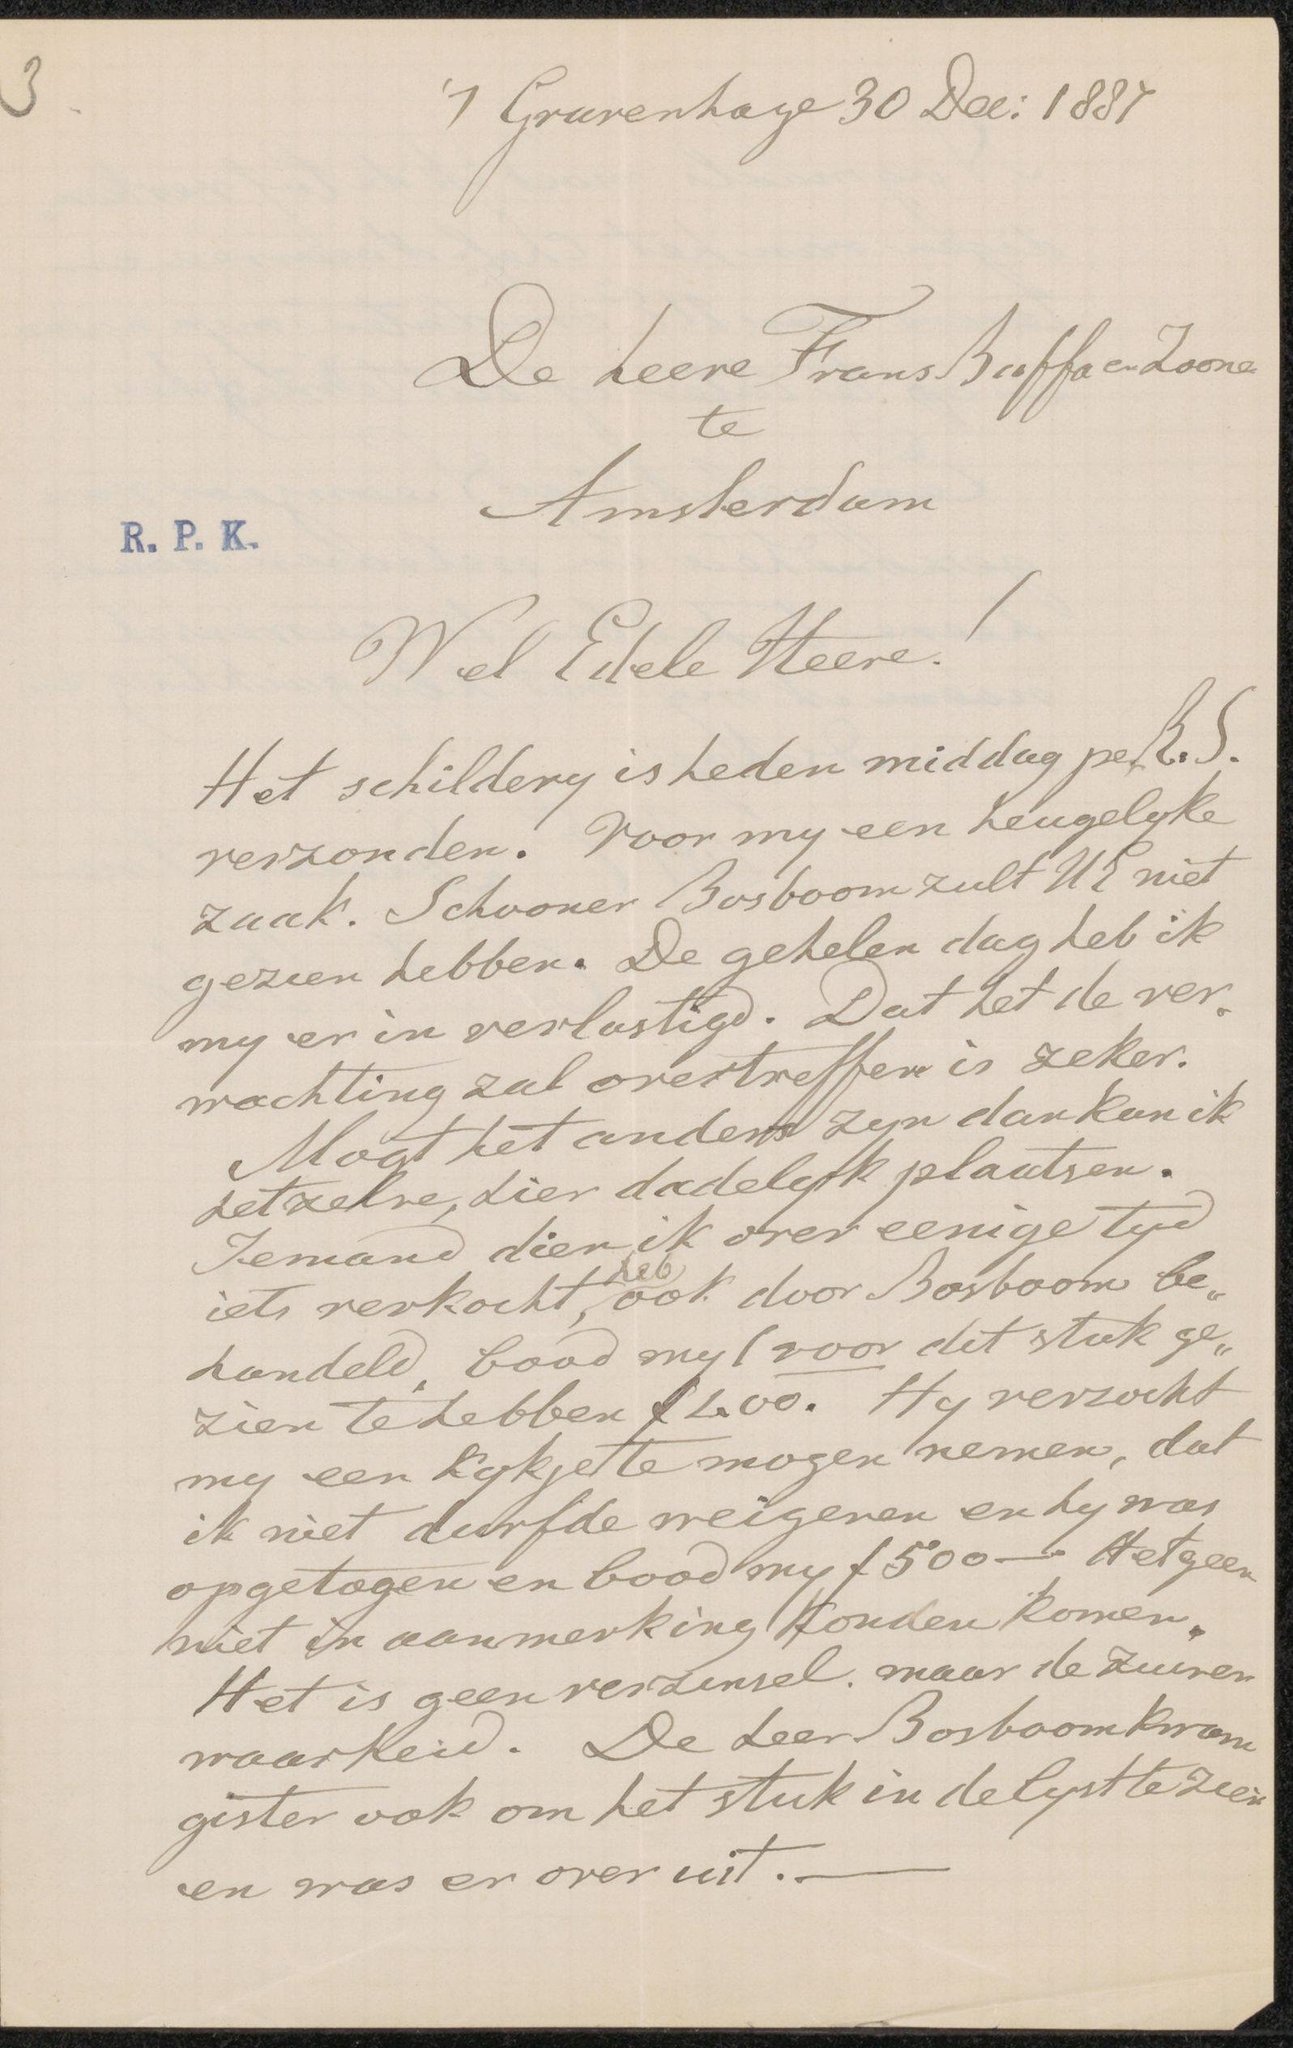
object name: letter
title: Brief aan Frans Buffa en Zonen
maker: carel jacobus behr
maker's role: draughtsman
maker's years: 1812-1895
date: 1887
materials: ink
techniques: pen, writing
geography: the hague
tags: painter, print maker, johannes bosboom, art trade, art shop, painting (including book-illumination, miniature-painting), money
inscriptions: collector's mark: ‘RPK’ Lugt 2233